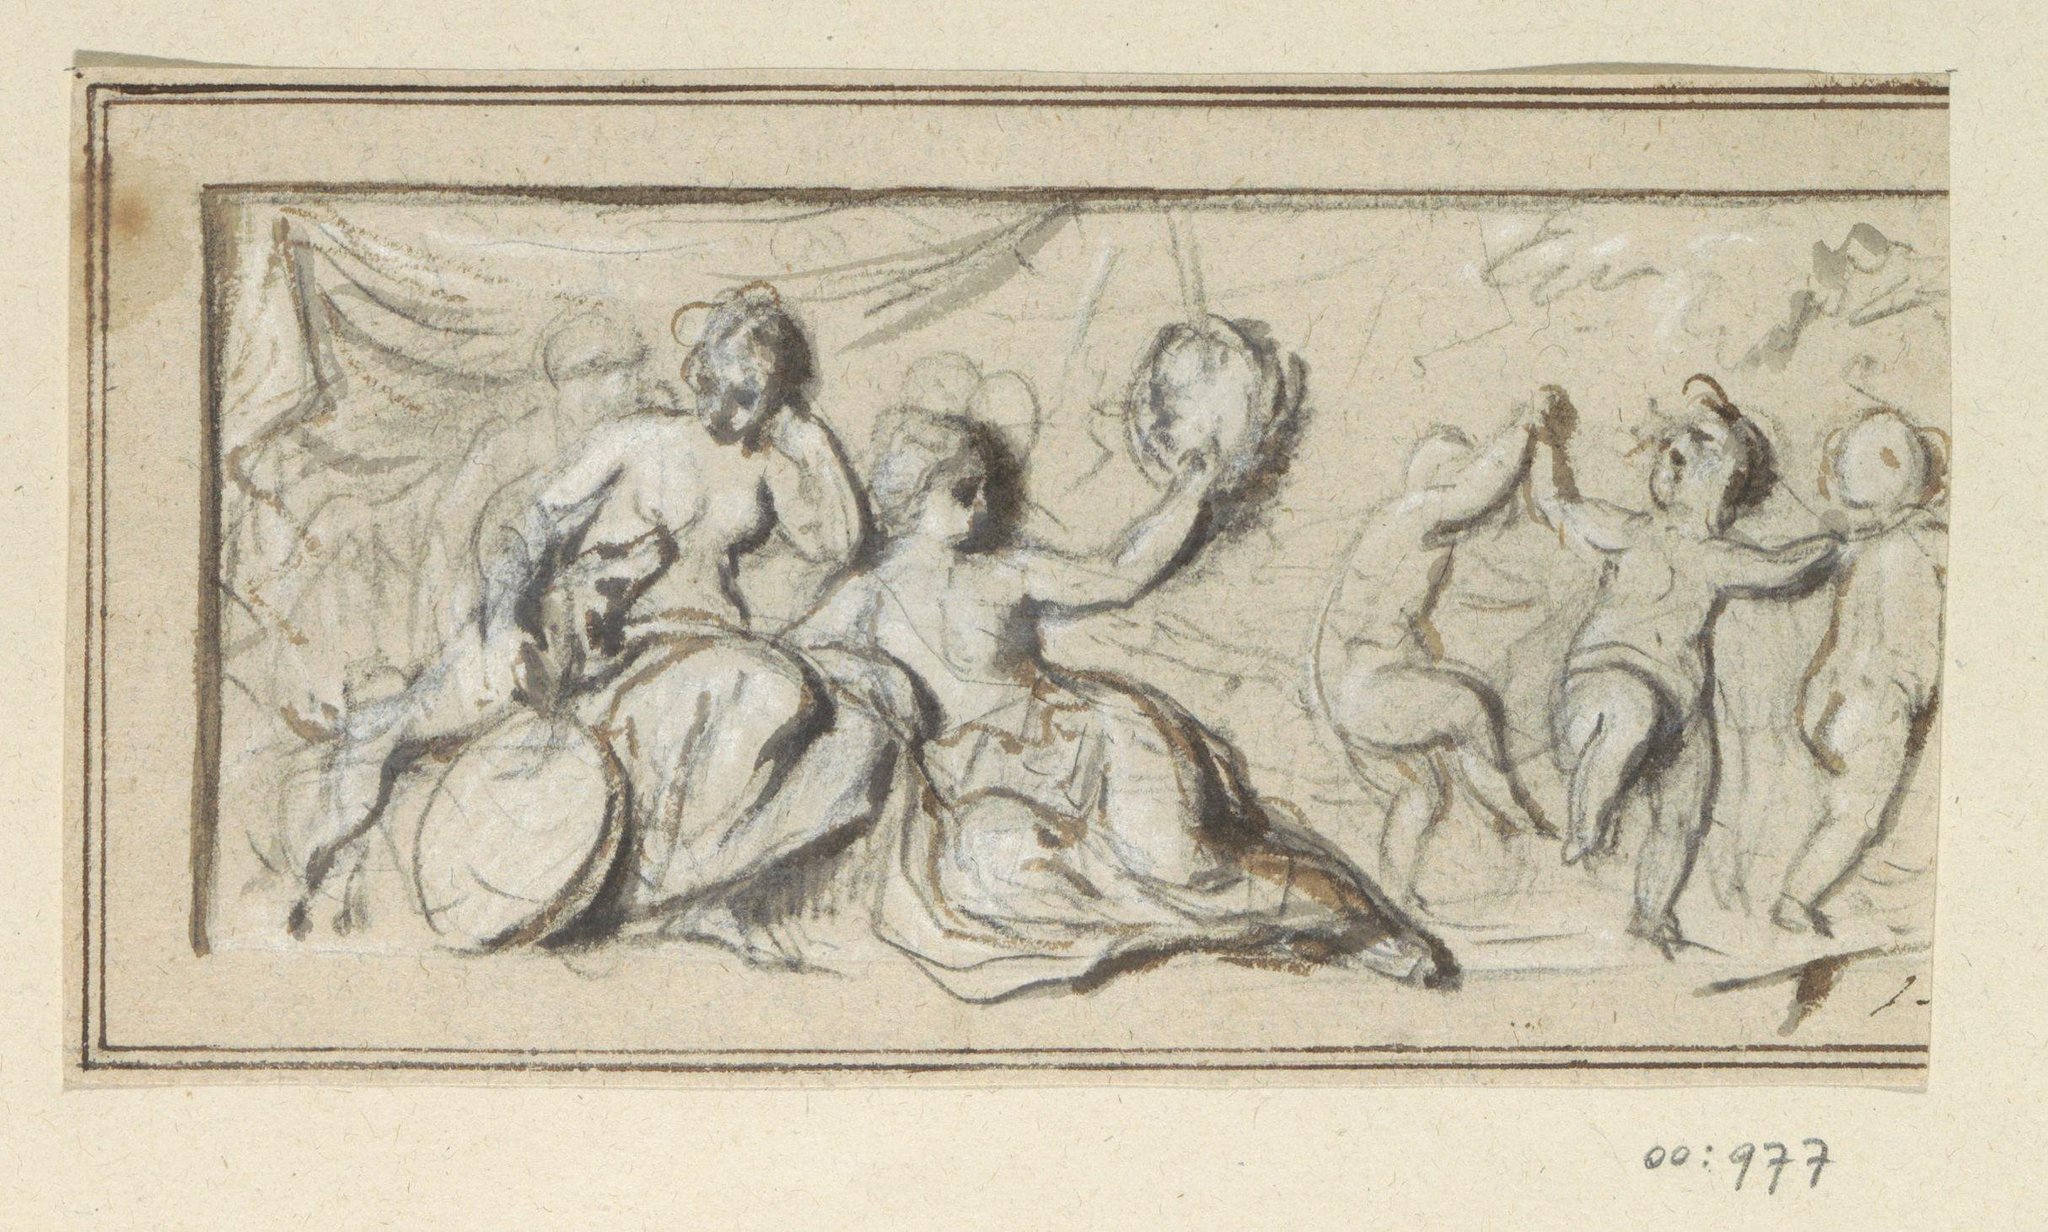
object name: drawing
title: Ontwerp voor een fries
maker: jurriaan andriessen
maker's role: draughtsman, painter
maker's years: 1742-1819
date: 1760-1819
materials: paper, pencil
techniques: brush, pen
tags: decorations (interior of the house), classical mythology and ancient history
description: Deel van een mythologisch tafereel. Tekening maakt deel uit van een album.